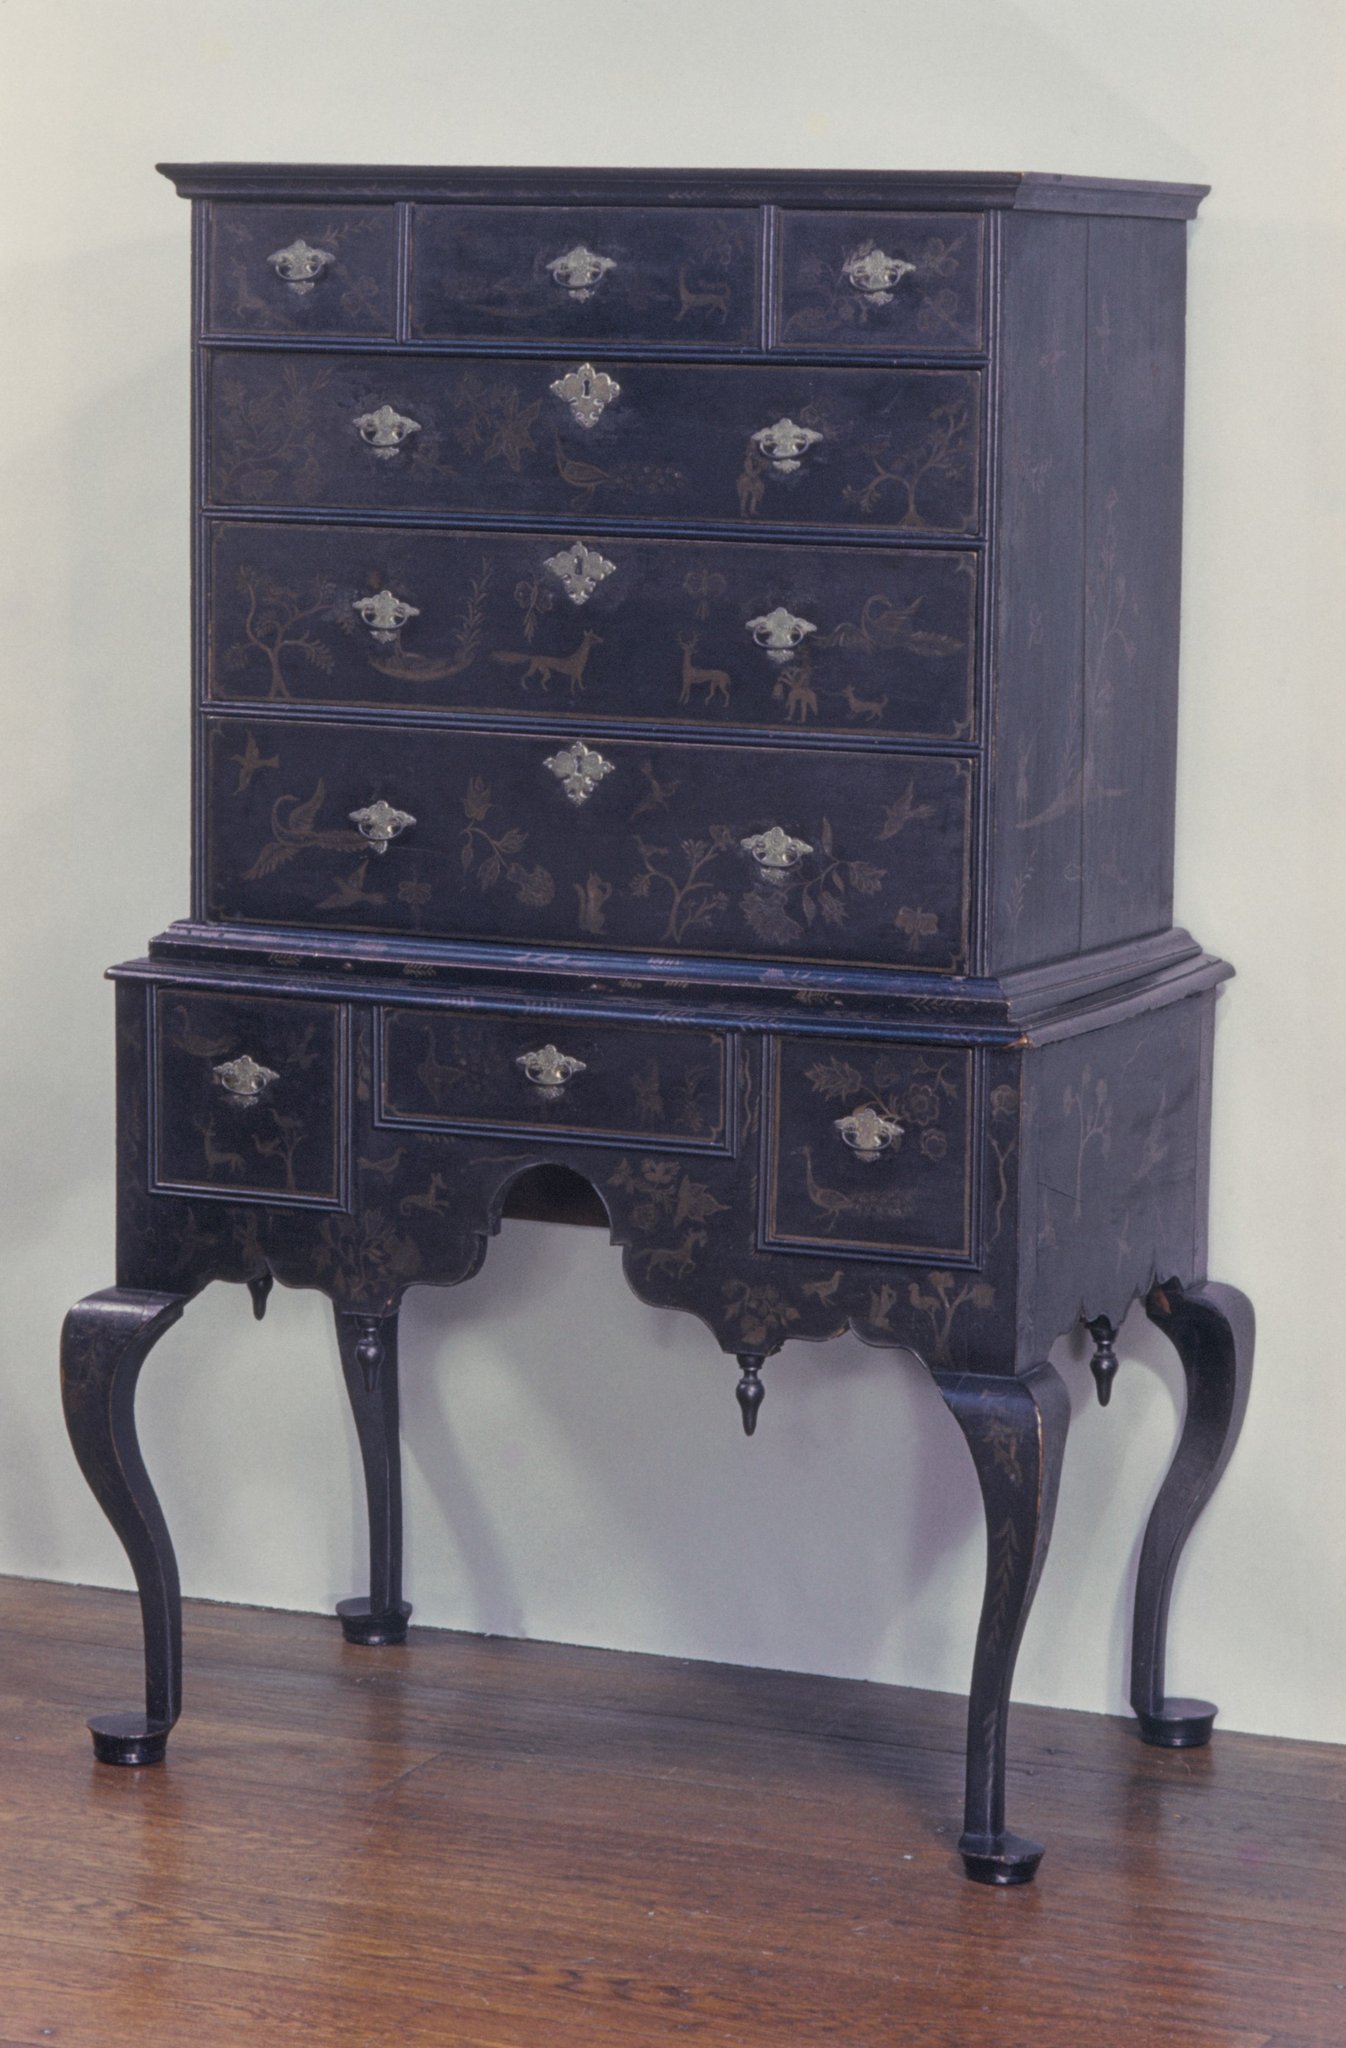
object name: high chest of drawer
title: High chest of drawers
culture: american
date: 1730-1740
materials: wood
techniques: painting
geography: united states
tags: animals,birds,peacocks